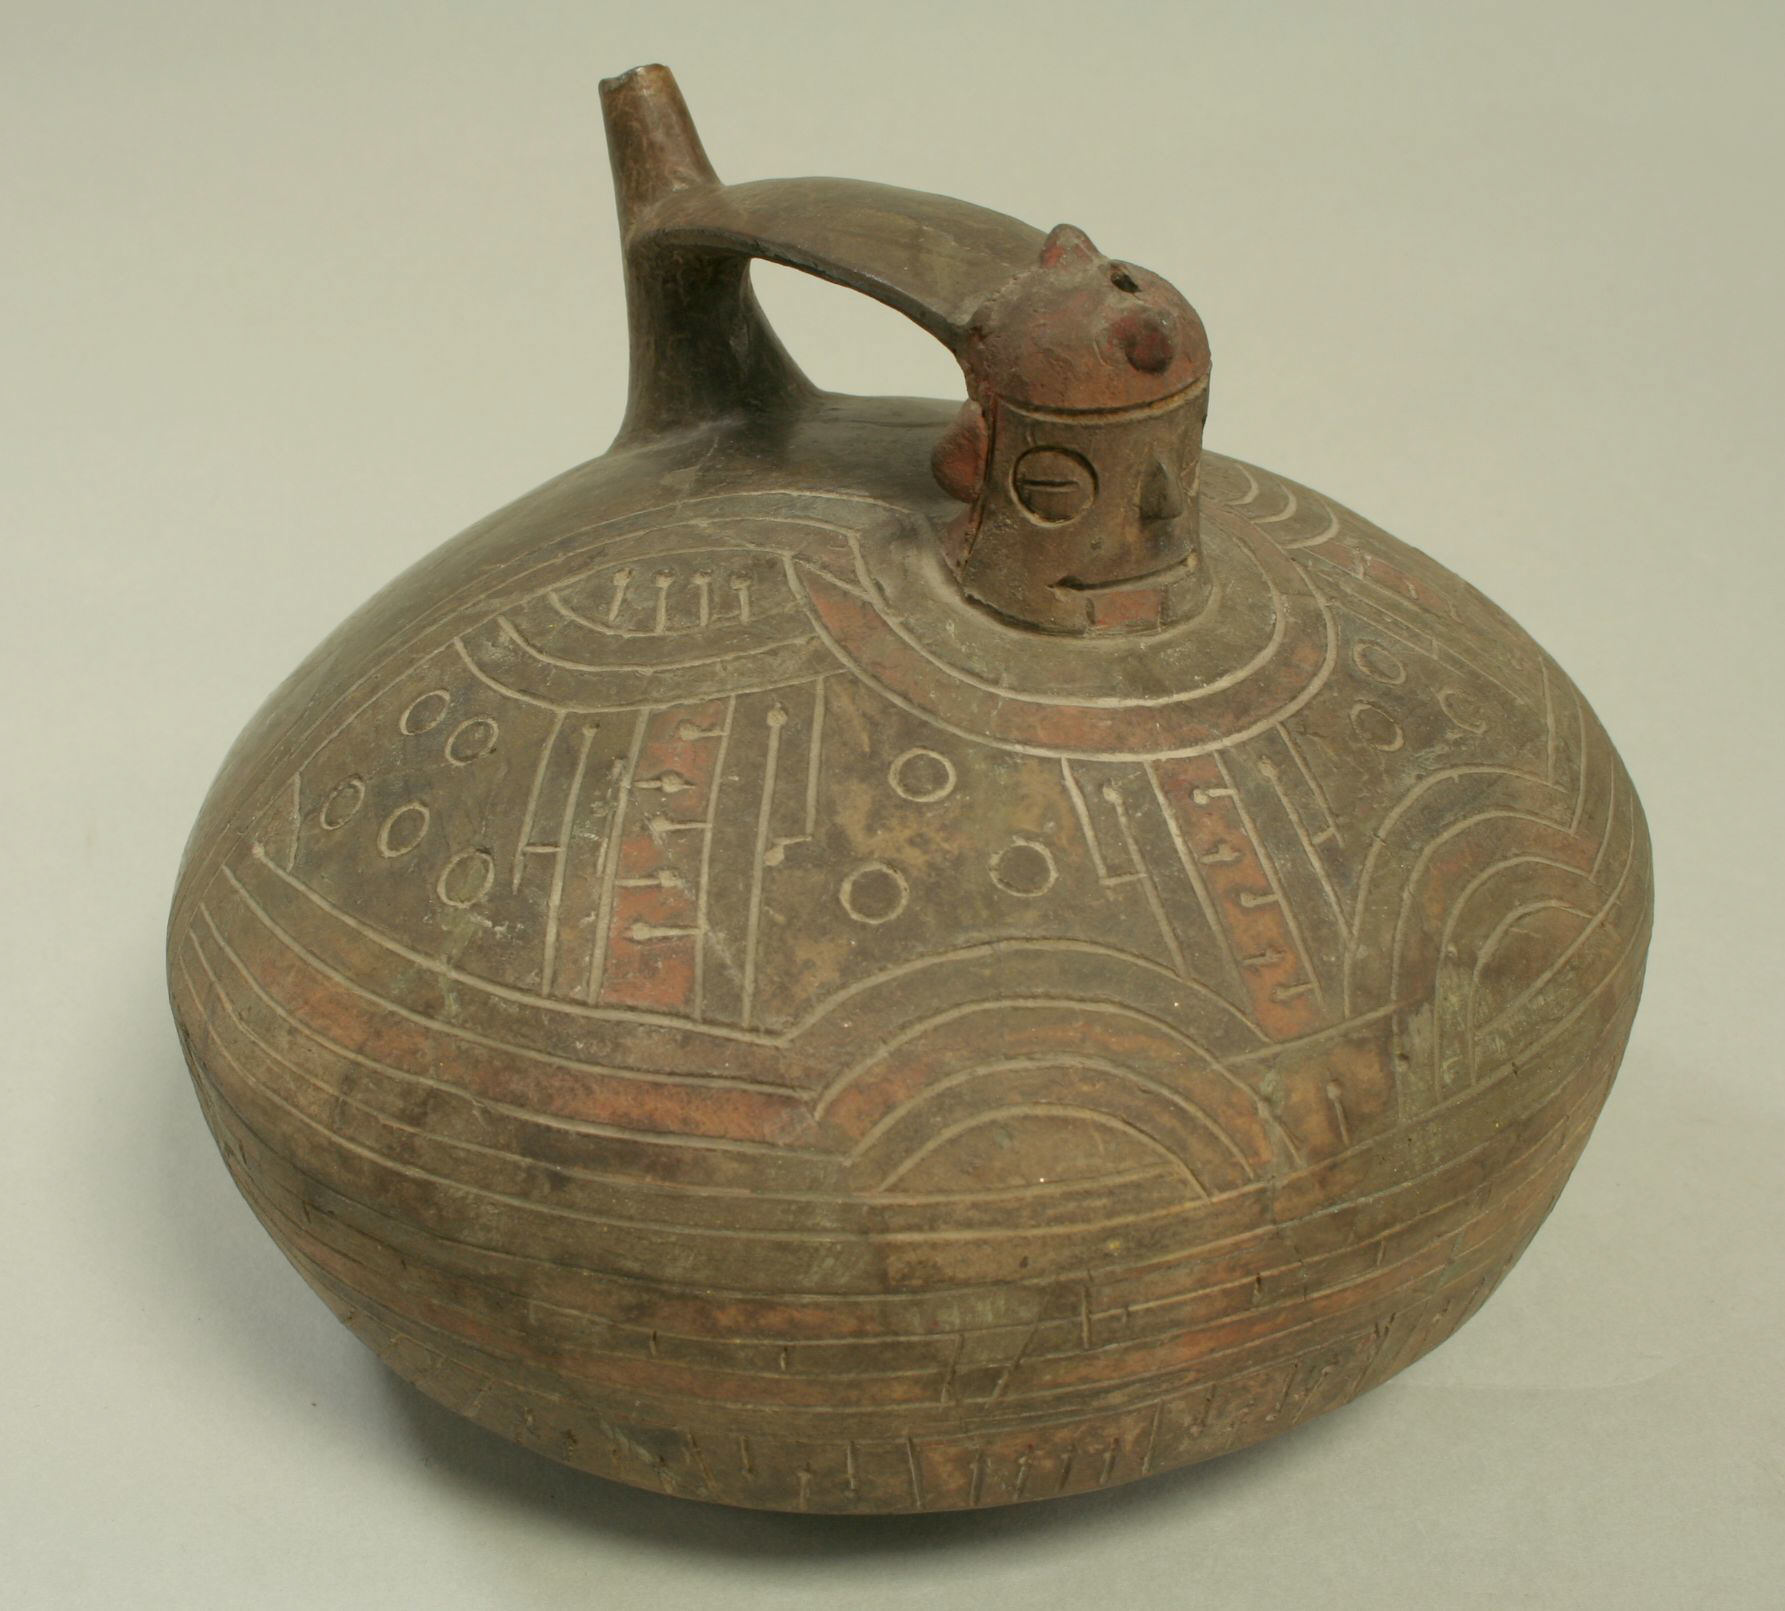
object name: bottle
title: Bottle, Feline Face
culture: paracas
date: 300-101 BCE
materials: ceramic, pigment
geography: peru